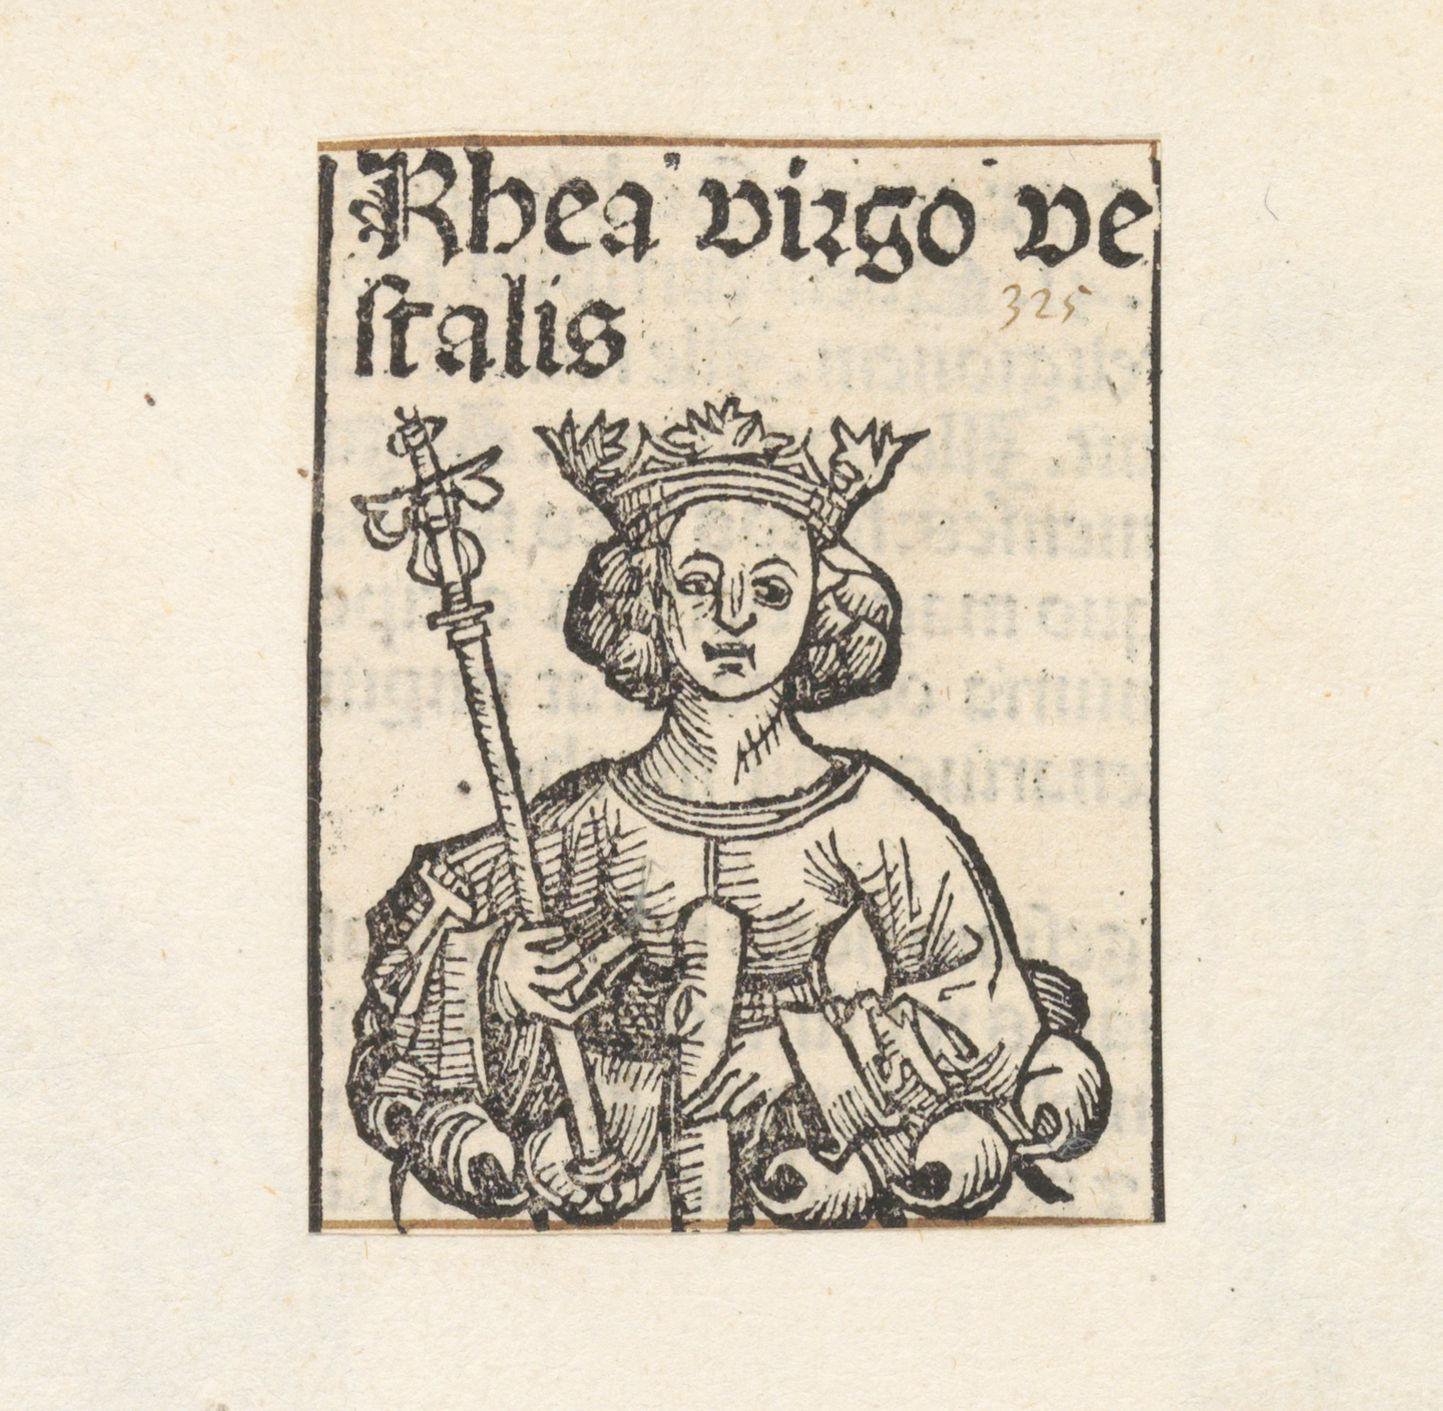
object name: print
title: Liber Chronicarum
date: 1493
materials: paper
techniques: letterpress printing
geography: nuremberg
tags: (story of) rhea silvia, queen, empress, etc. (wife of a ruler)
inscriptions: inscription: ‘325’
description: Een bloemkelk met een koningin, naar voren gekeerd. Ze heeft een scepter in haar handen. De voorstelling is onderdeel van de opeenvolging Romeinse koningen in de Liber Chronicarum. De tekst identificeert de vrouw als Rhea Silvia, moeder van Romulus en Remus. De prent maakt deel uit van een album.